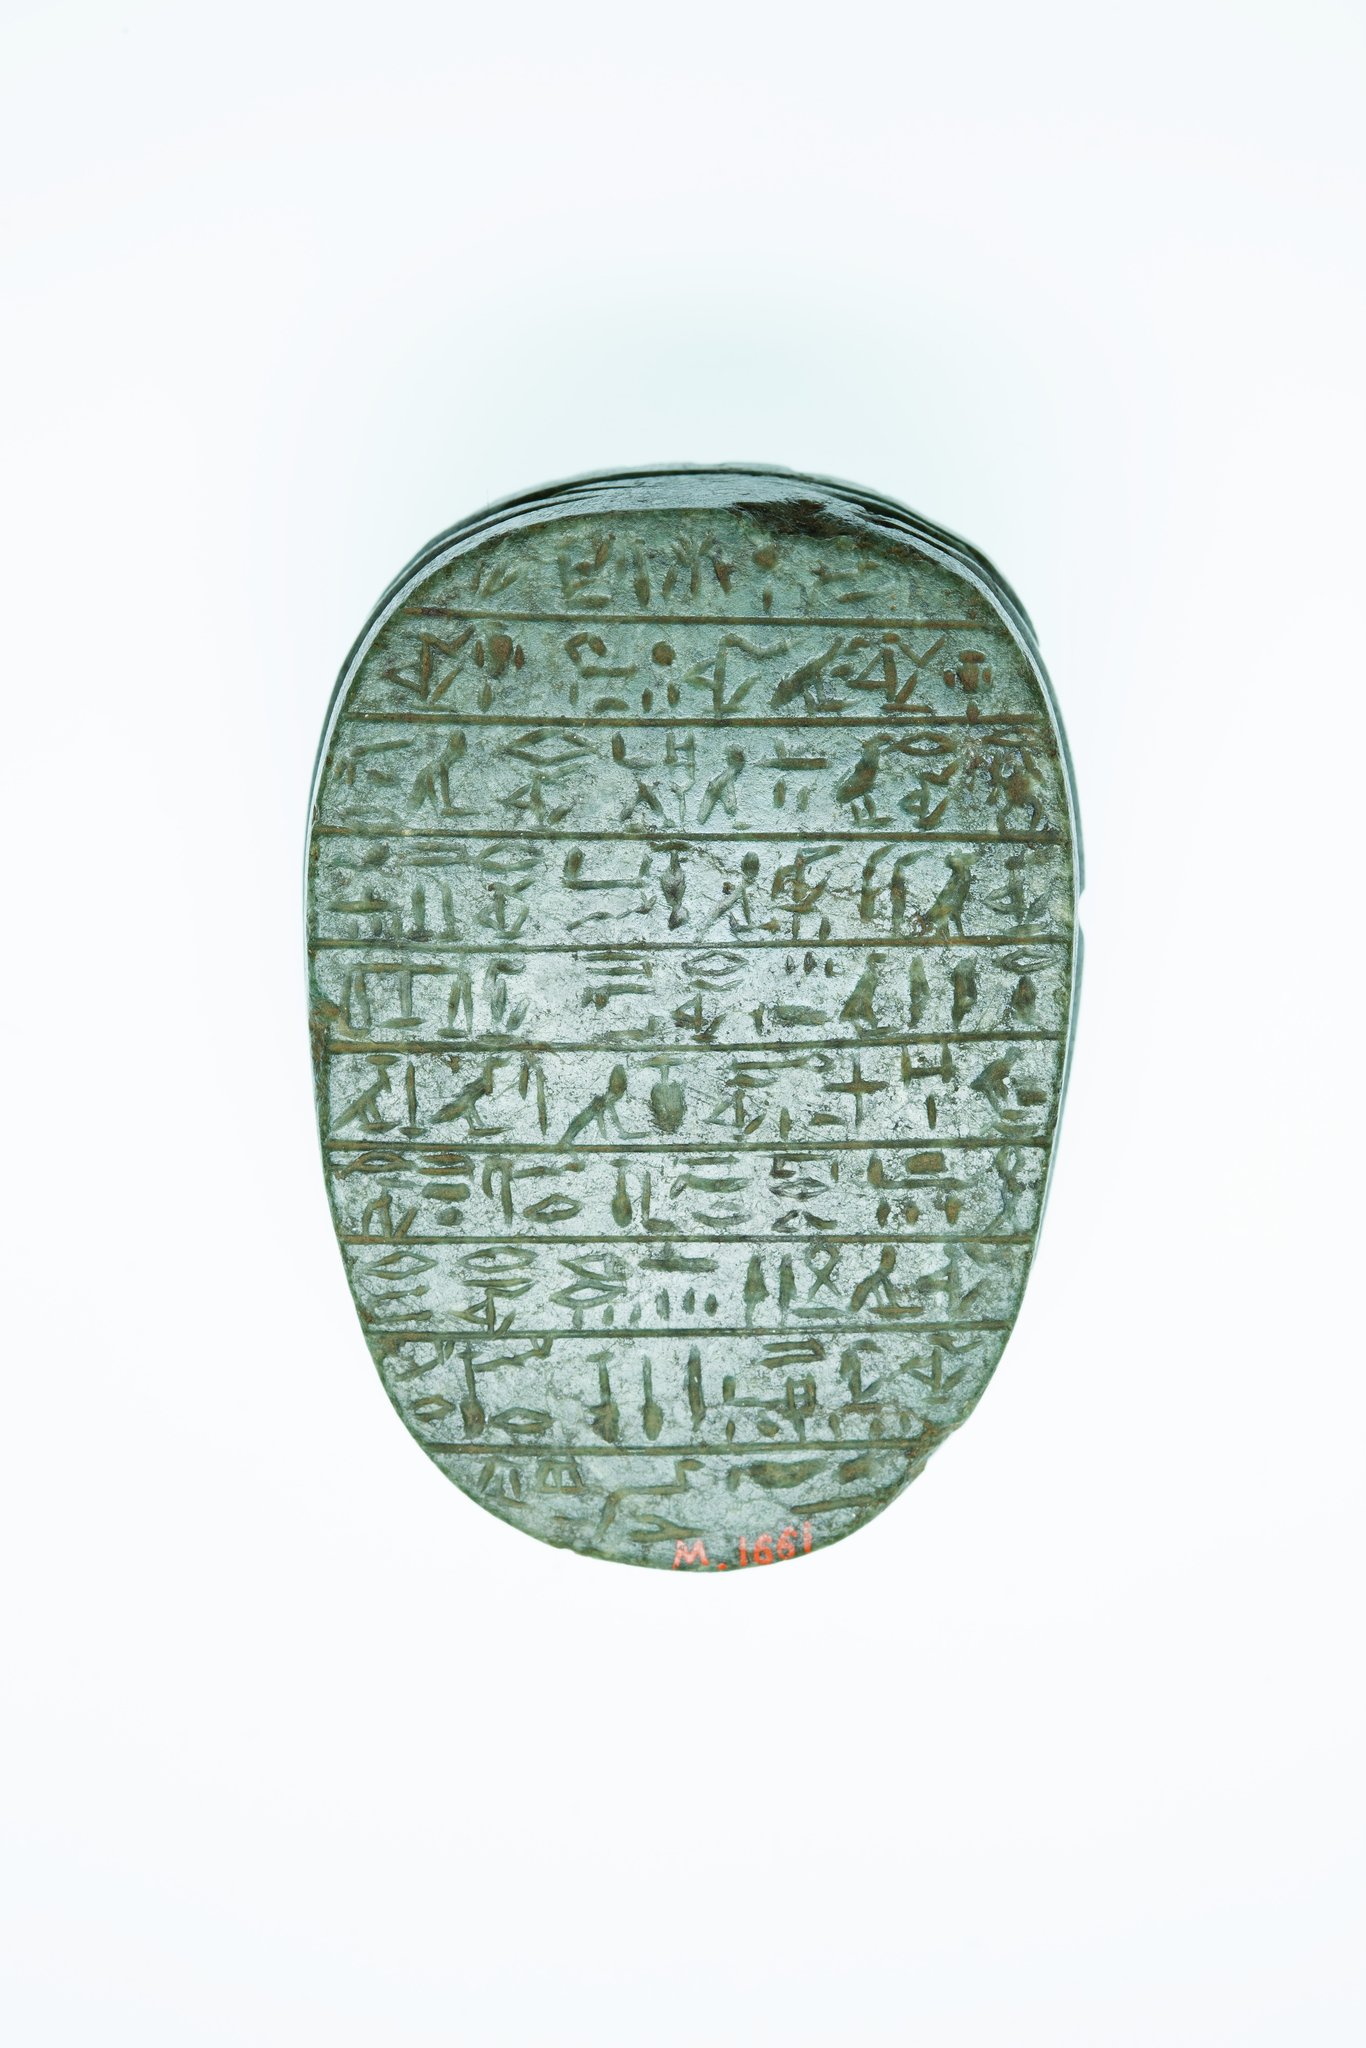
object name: scarab, ramesses ii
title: Heart Scarab of Ramesses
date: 1295-1070 BCE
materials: stone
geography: egypt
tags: hieroglyphs,scarabs